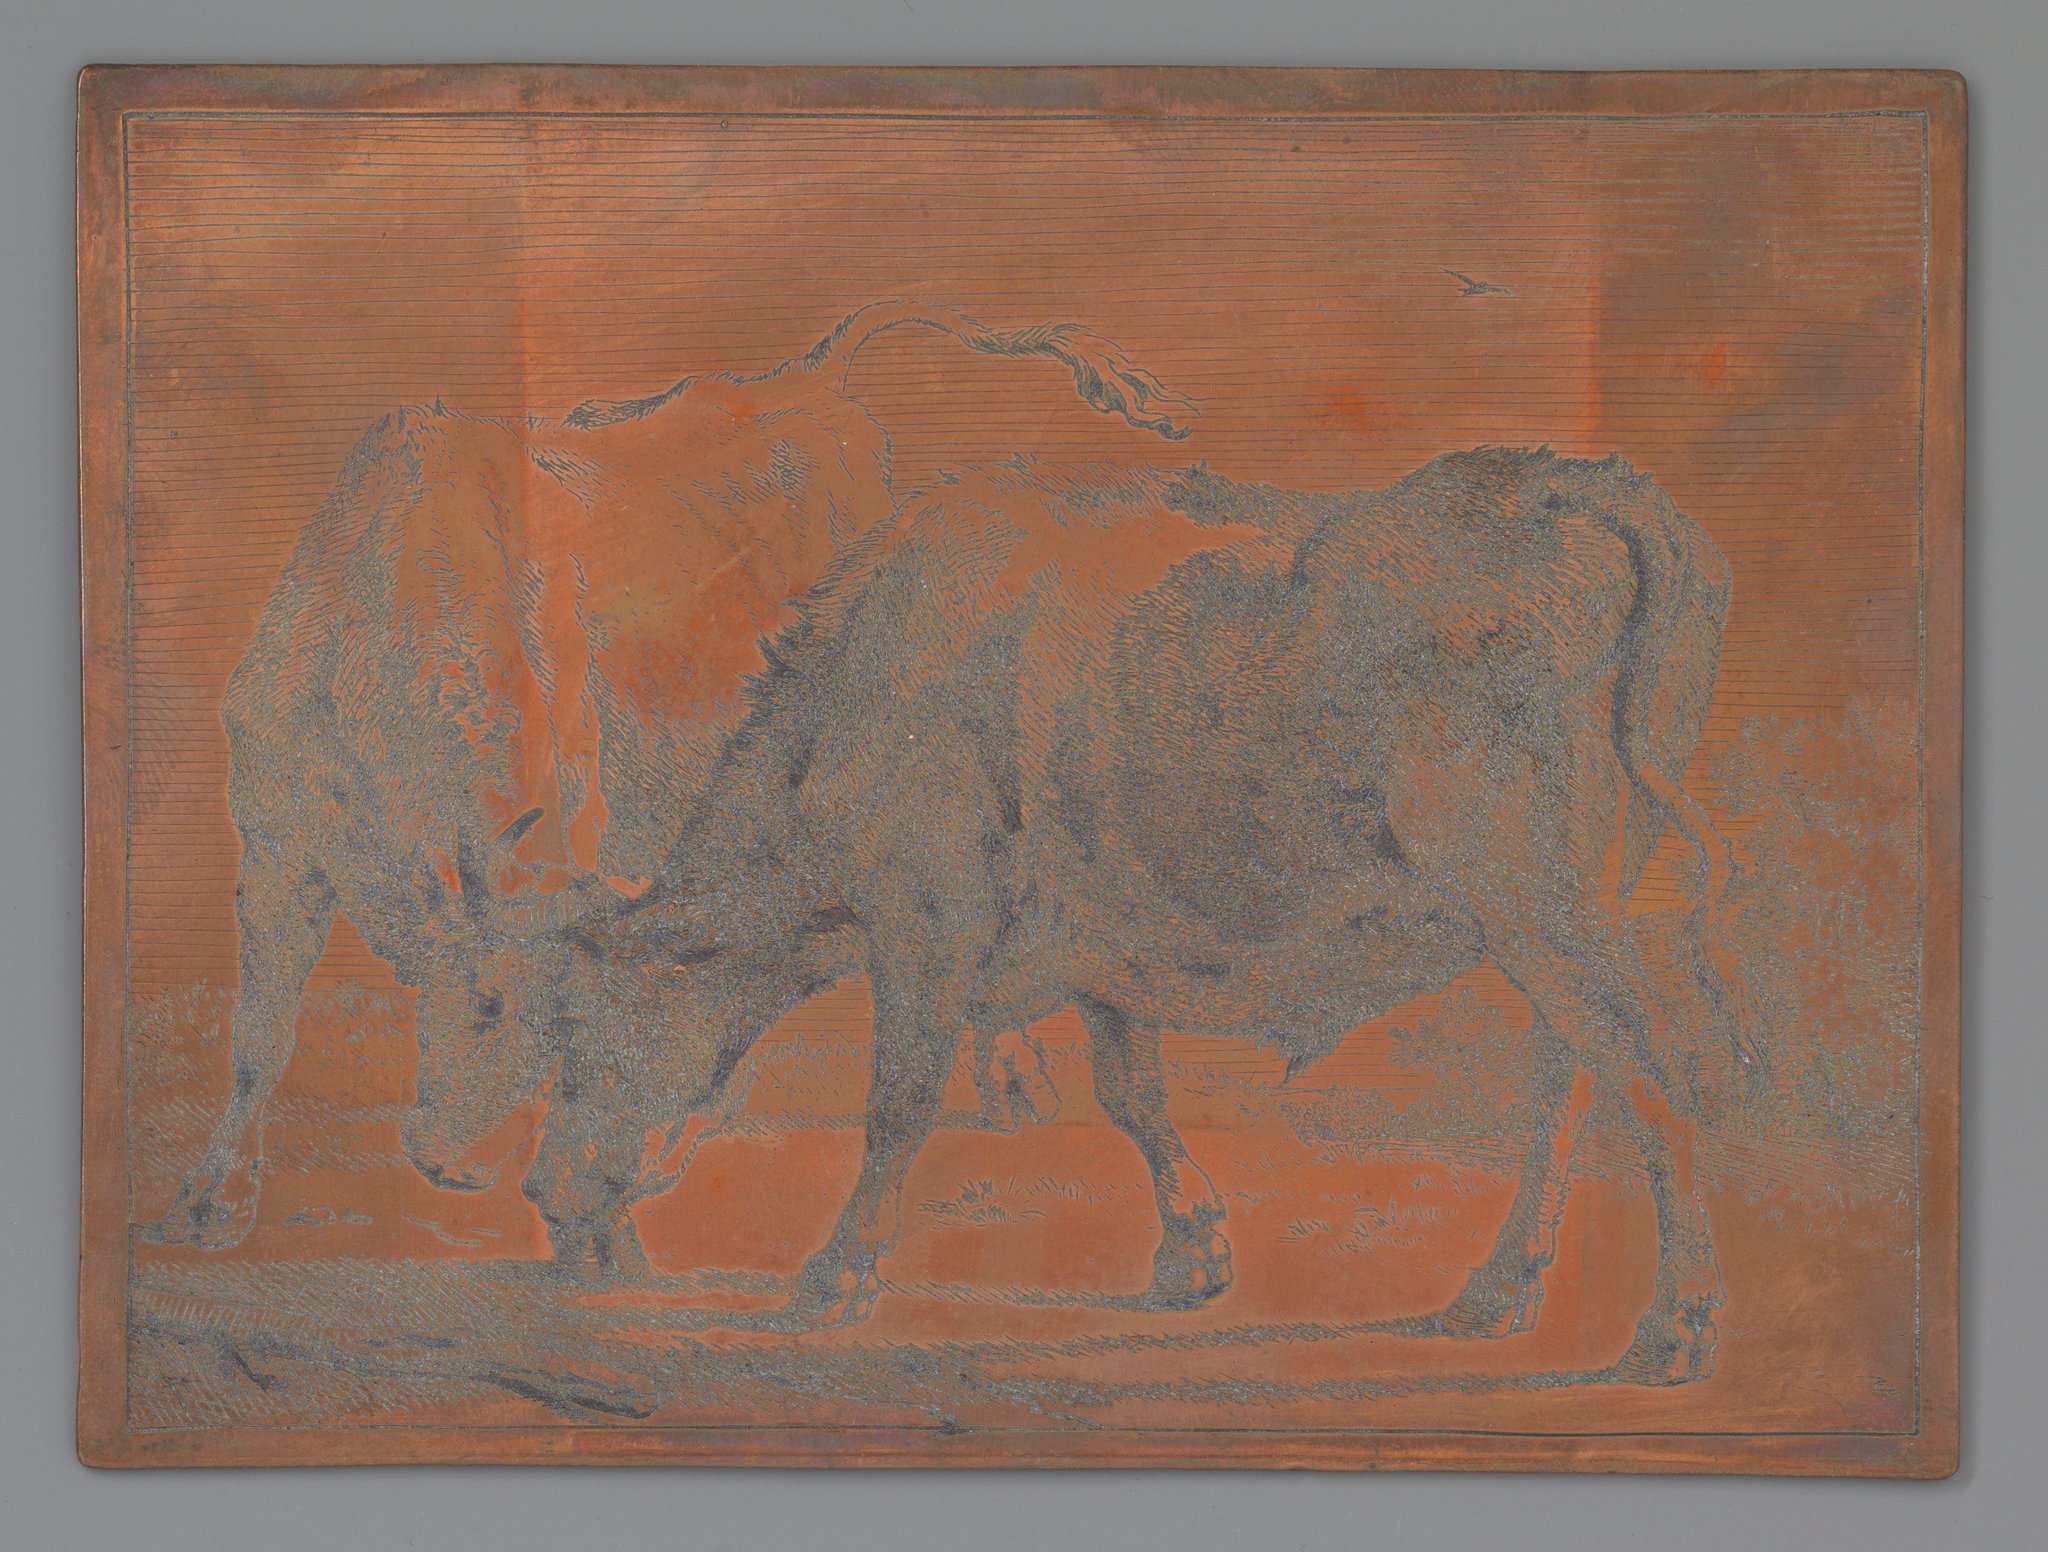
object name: copper plate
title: Het Bullenboekje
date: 1650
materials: copper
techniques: etching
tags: ox